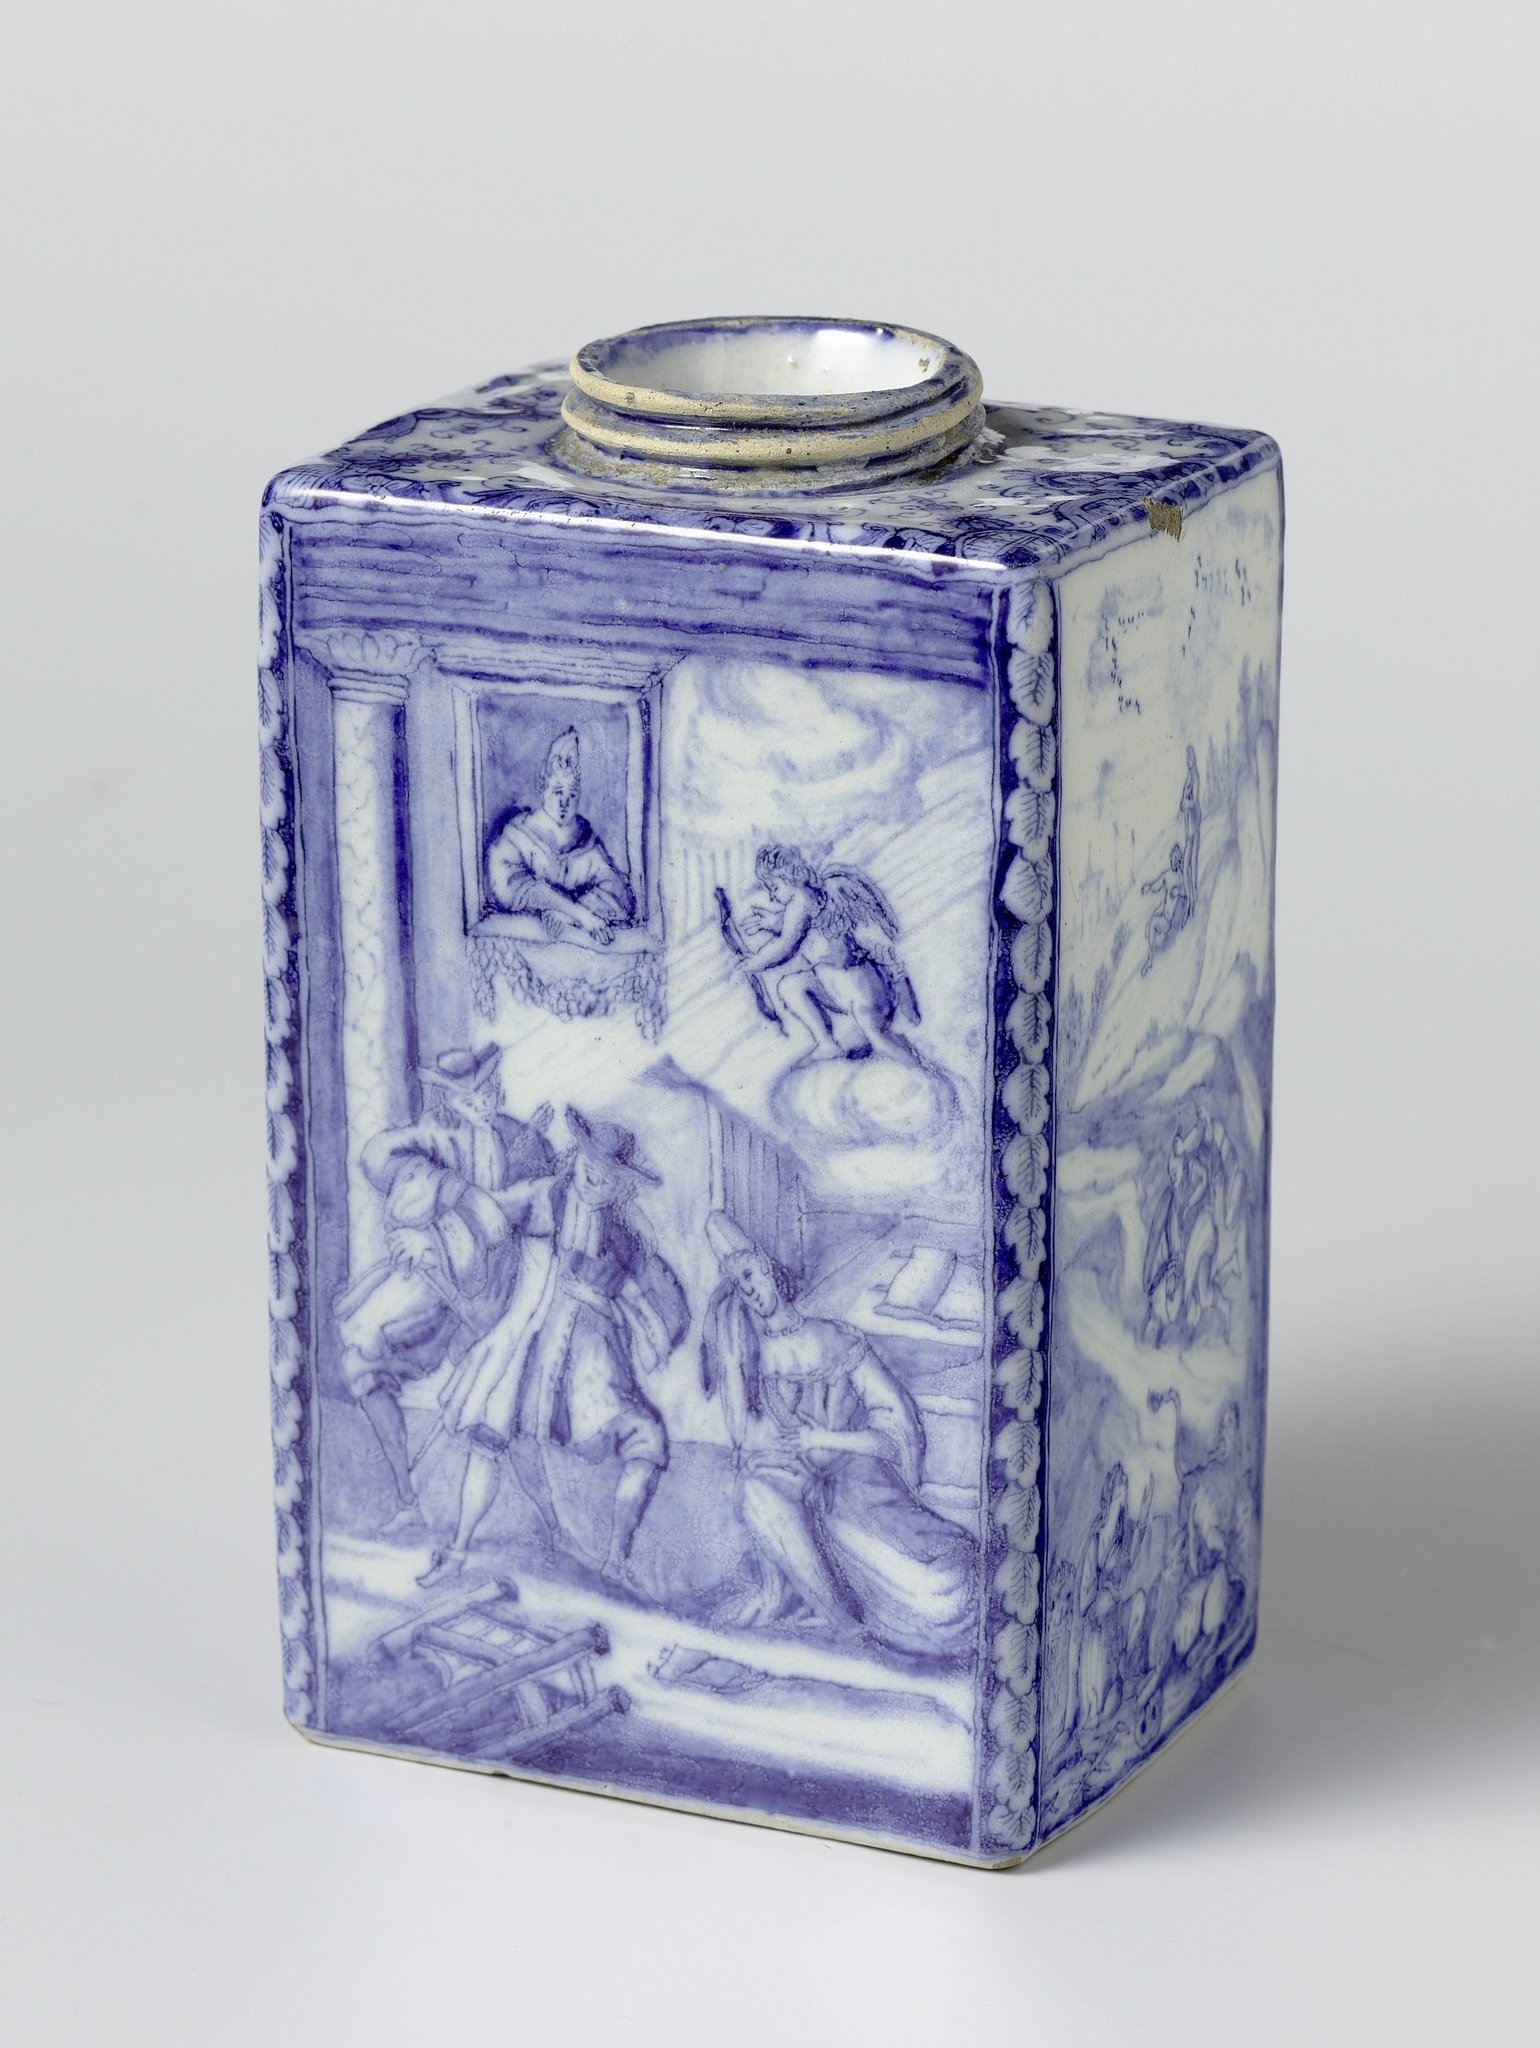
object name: tea caddy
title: Theebus, beschilderd met oudtestamentische en amoreuze scènes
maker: johannes verhagen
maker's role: plateelbakker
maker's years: -1739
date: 1727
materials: earthenware, glaze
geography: delft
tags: cupid shooting a dart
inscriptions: date: ‘1727’, signature: ‘I.V.H.’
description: Verhagen had van ca. 1720 t/m 1729 een huisoven waar hij poppengoed, maar ook enkele grotere stukken maakte. In 1729 kocht hij De Paauw, die hij tot zijn dood in 1739 bezat. Zijn weduwe zette de fabriek nog een jaar voort, voor ze deze aan Jacobus de Milde verkocht.